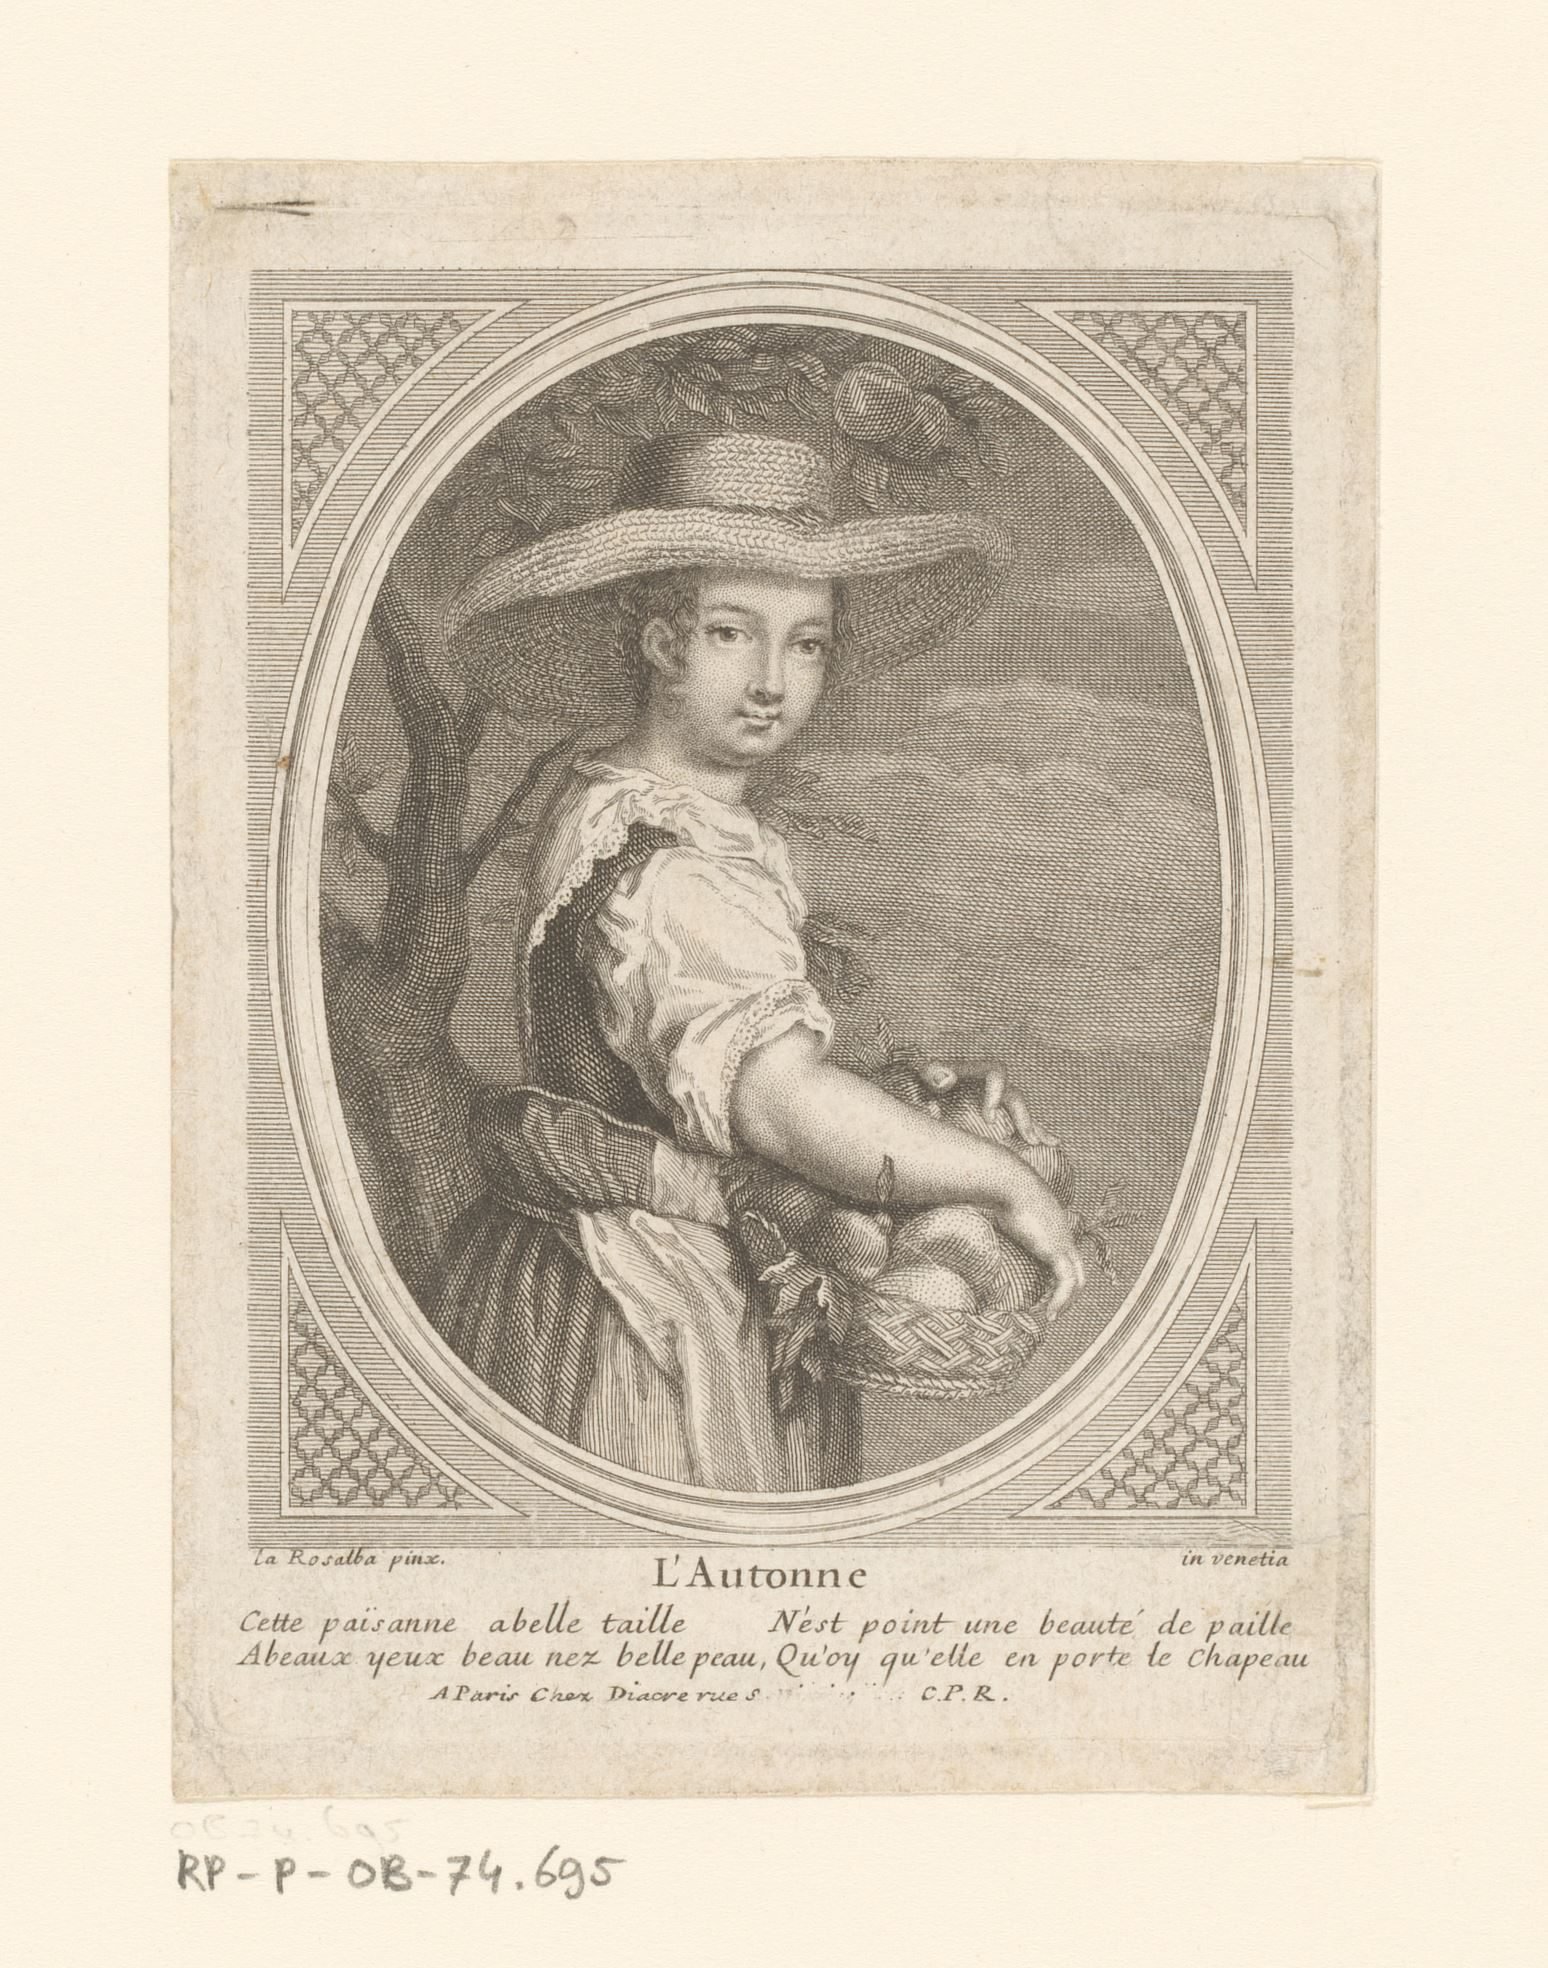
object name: print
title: Personificatie van de Herfst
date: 1709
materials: paper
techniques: engraving, etching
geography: france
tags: autumn, fall, 'autumnus'; 'autunno' (ripa)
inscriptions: collector's mark: Lugt 1237, number: ‘<2662.>’, inscription: ‘aant. IIa’, number: ‘1336a’, collector's mark: Lugt 2228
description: Maakt waarschijnlijk deel uit van een serie met de vier seizoenen.